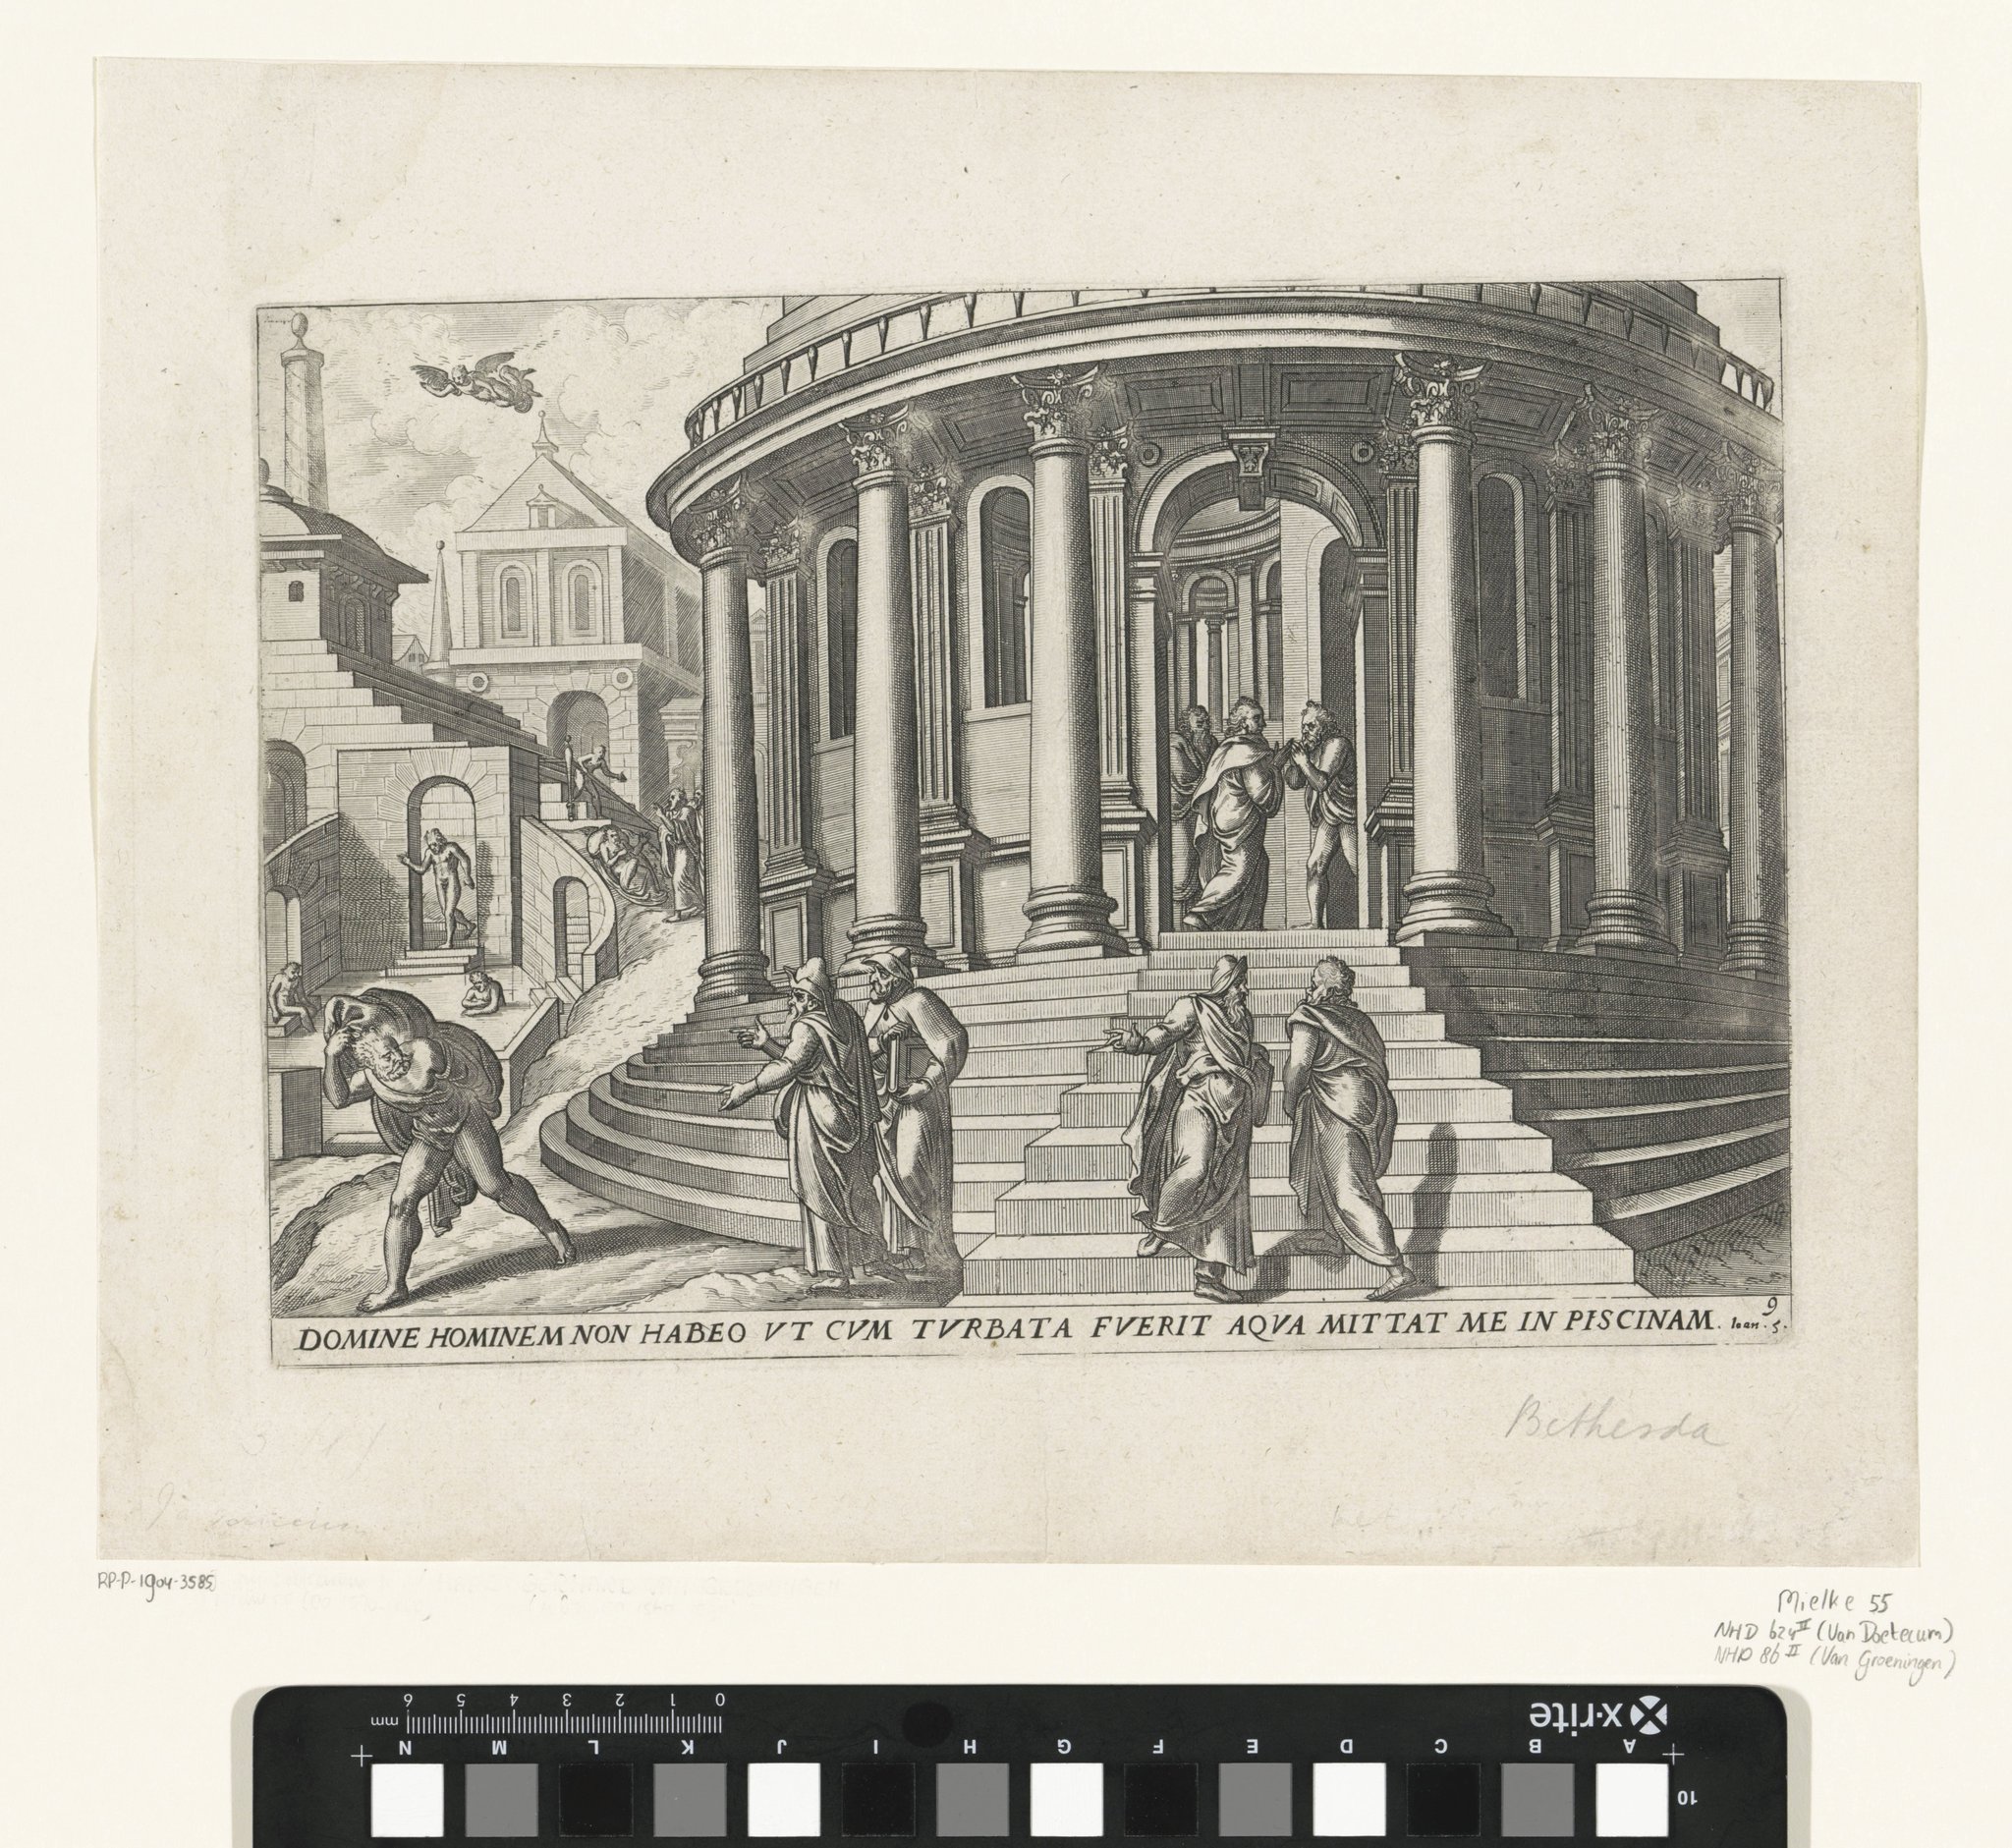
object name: print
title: Theatrum biblicum (...)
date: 1585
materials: paper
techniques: engraving, etching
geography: amsterdam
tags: the paralytic man is cured and walks away, sick people lying near the pool of bethesda ~ christ healing paralytics (john 5:1-9)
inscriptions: collector's mark: Lugt 2228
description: Links op de achtergrond wachten zieken bij het bad van Betzata tot een engel komt om het water in beweging te brengen. Een man die al achtendertig jaar ziek is en niemand heeft om hem naar het water te dragen ligt rechts van het bad en wordt door Christus genezen. Christus geeft hem de opdracht zijn mat op te pakken en te lopen. Op de voorgrond loopt de genzen man met zijn mat op de rug langs de tempel. De farizeeën voor de tempel berispen hem, omdat hij op sabbat een mat draagt. Onder de voorstelling een verwijzing in het Latijn naar de Bijbeltekst in Joh. 5.